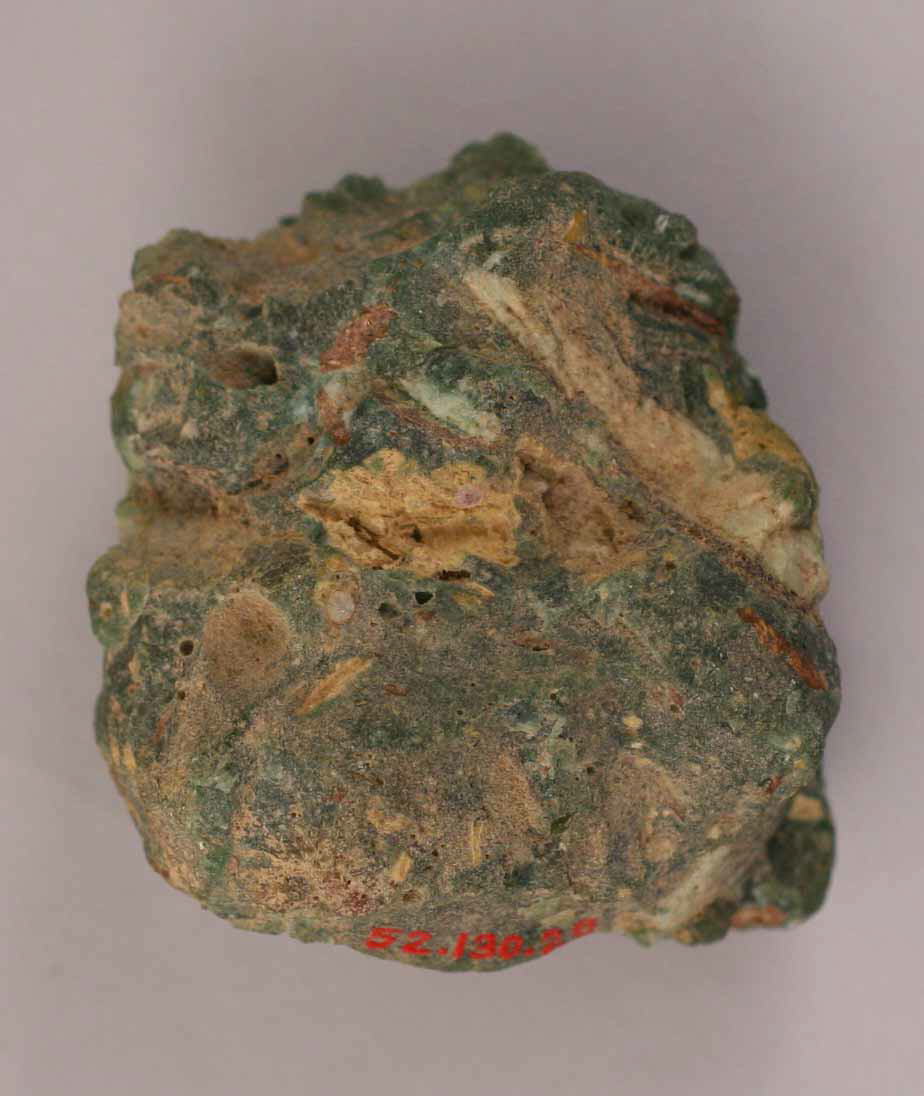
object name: fragment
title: Ceramic Fragment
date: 801-900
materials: glass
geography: iraq